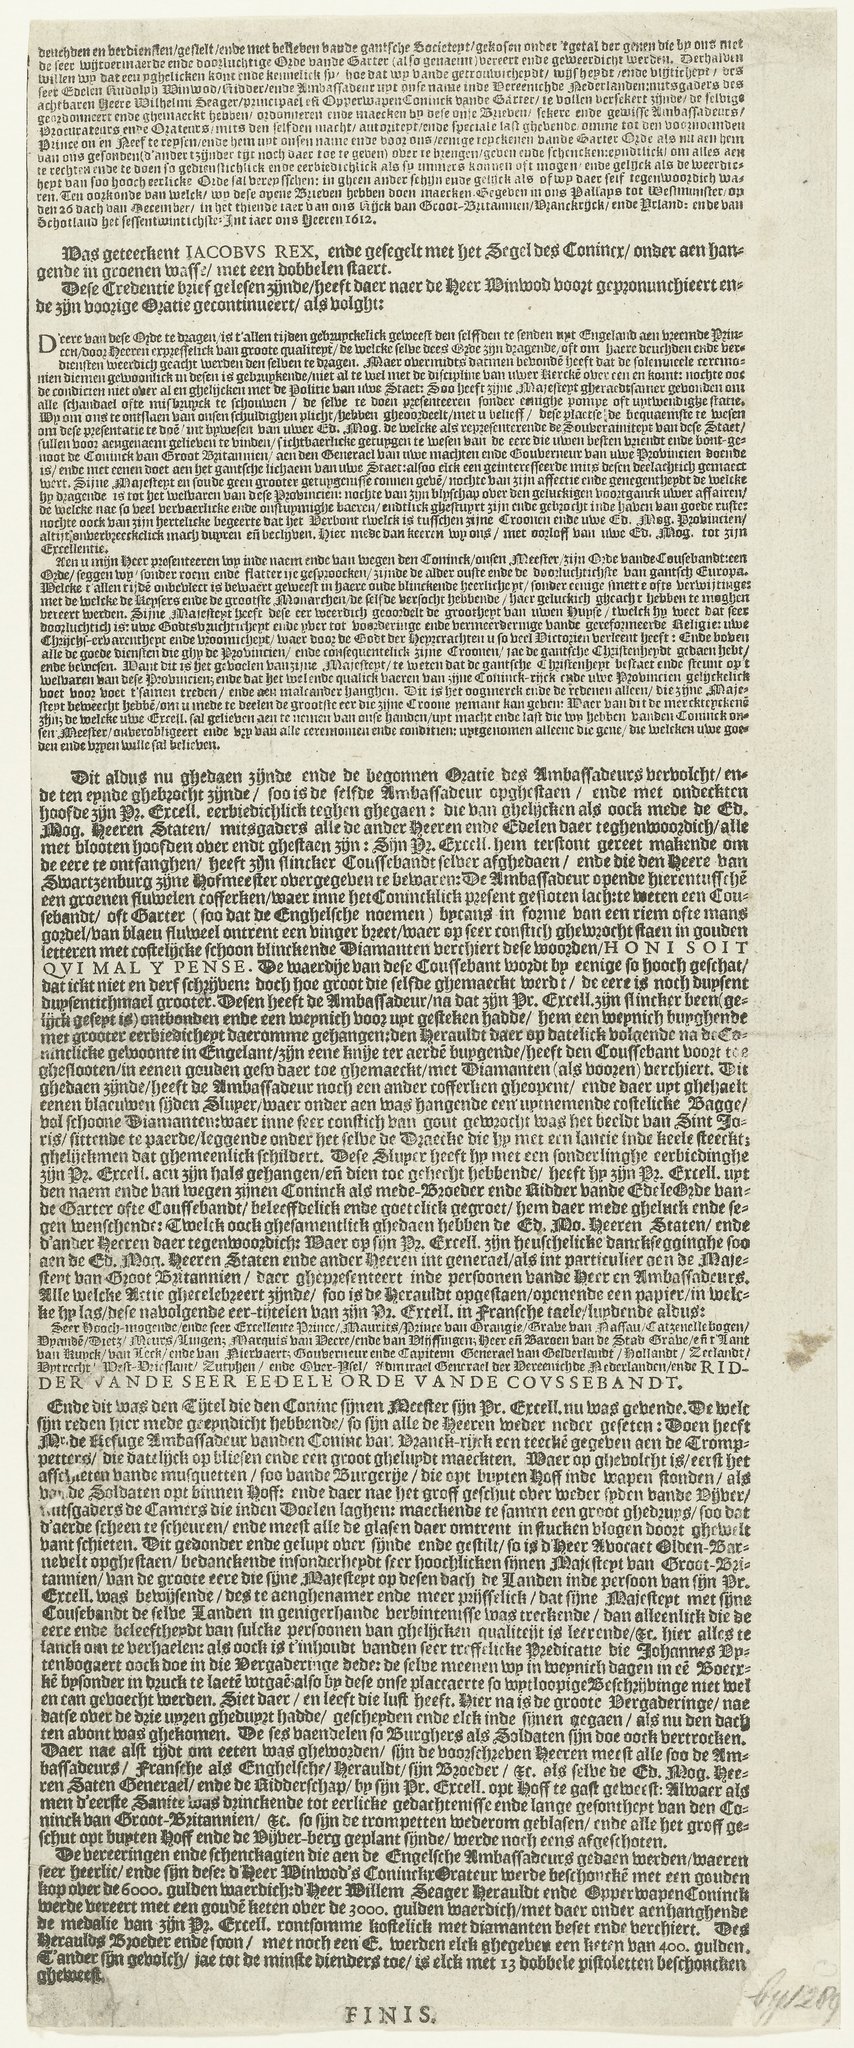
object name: text sheet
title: Deel van de beschrijving van de investituur van Maurits met de Orde van de Kousenband, 1613.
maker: simon frisius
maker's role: print maker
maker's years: 1570-1628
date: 1613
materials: paper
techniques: letterpress printing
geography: northern netherlands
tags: the hague, maurice (prince of orange), clothing (~ knighting ceremony), knighthood order (garter)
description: Deel van de beschrijving, één kolom in het Nederlands. Onderdeel van de prent van de investituur van Maurits met de Orde van de Kousenband, 4 februari 1613.